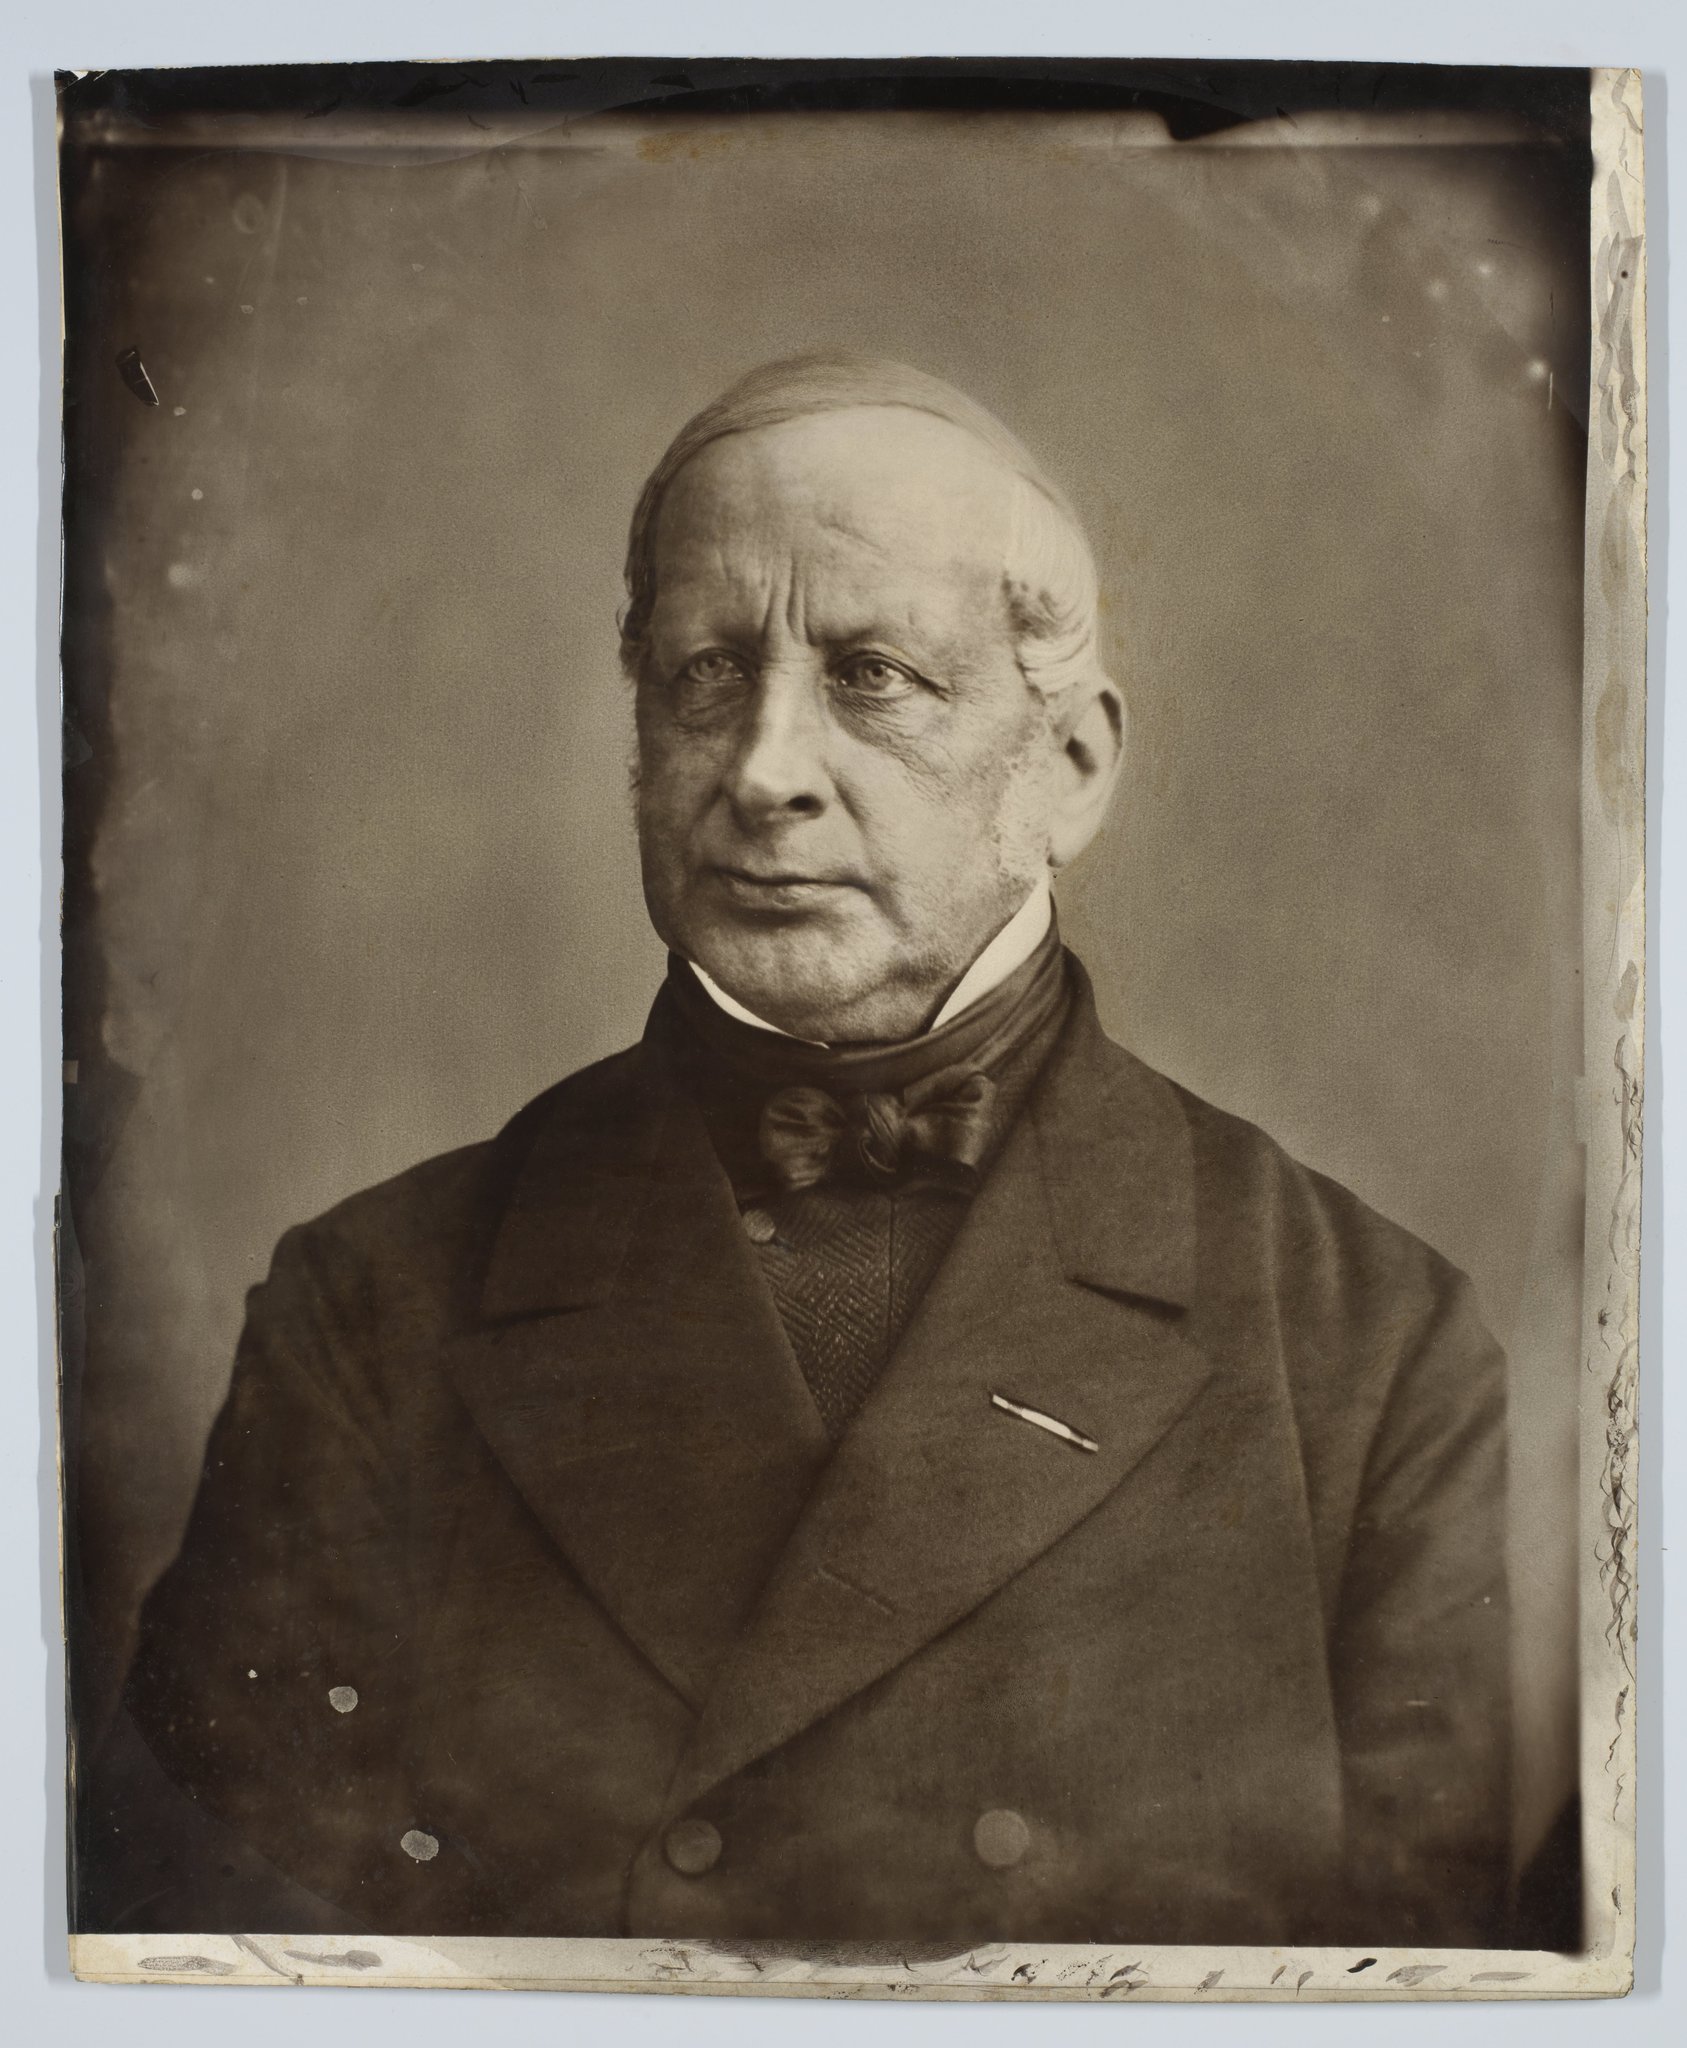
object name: photograph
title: Portret van Christiaan Pieter van Eeghen (1816-1889)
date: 1880-1890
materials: paper, photographic support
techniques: carbon print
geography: amsterdam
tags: christiaan pieter van eeghen (1816-1889)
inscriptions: collector's mark: ‘KOOLDRUK / WEGNER & MOTTU’